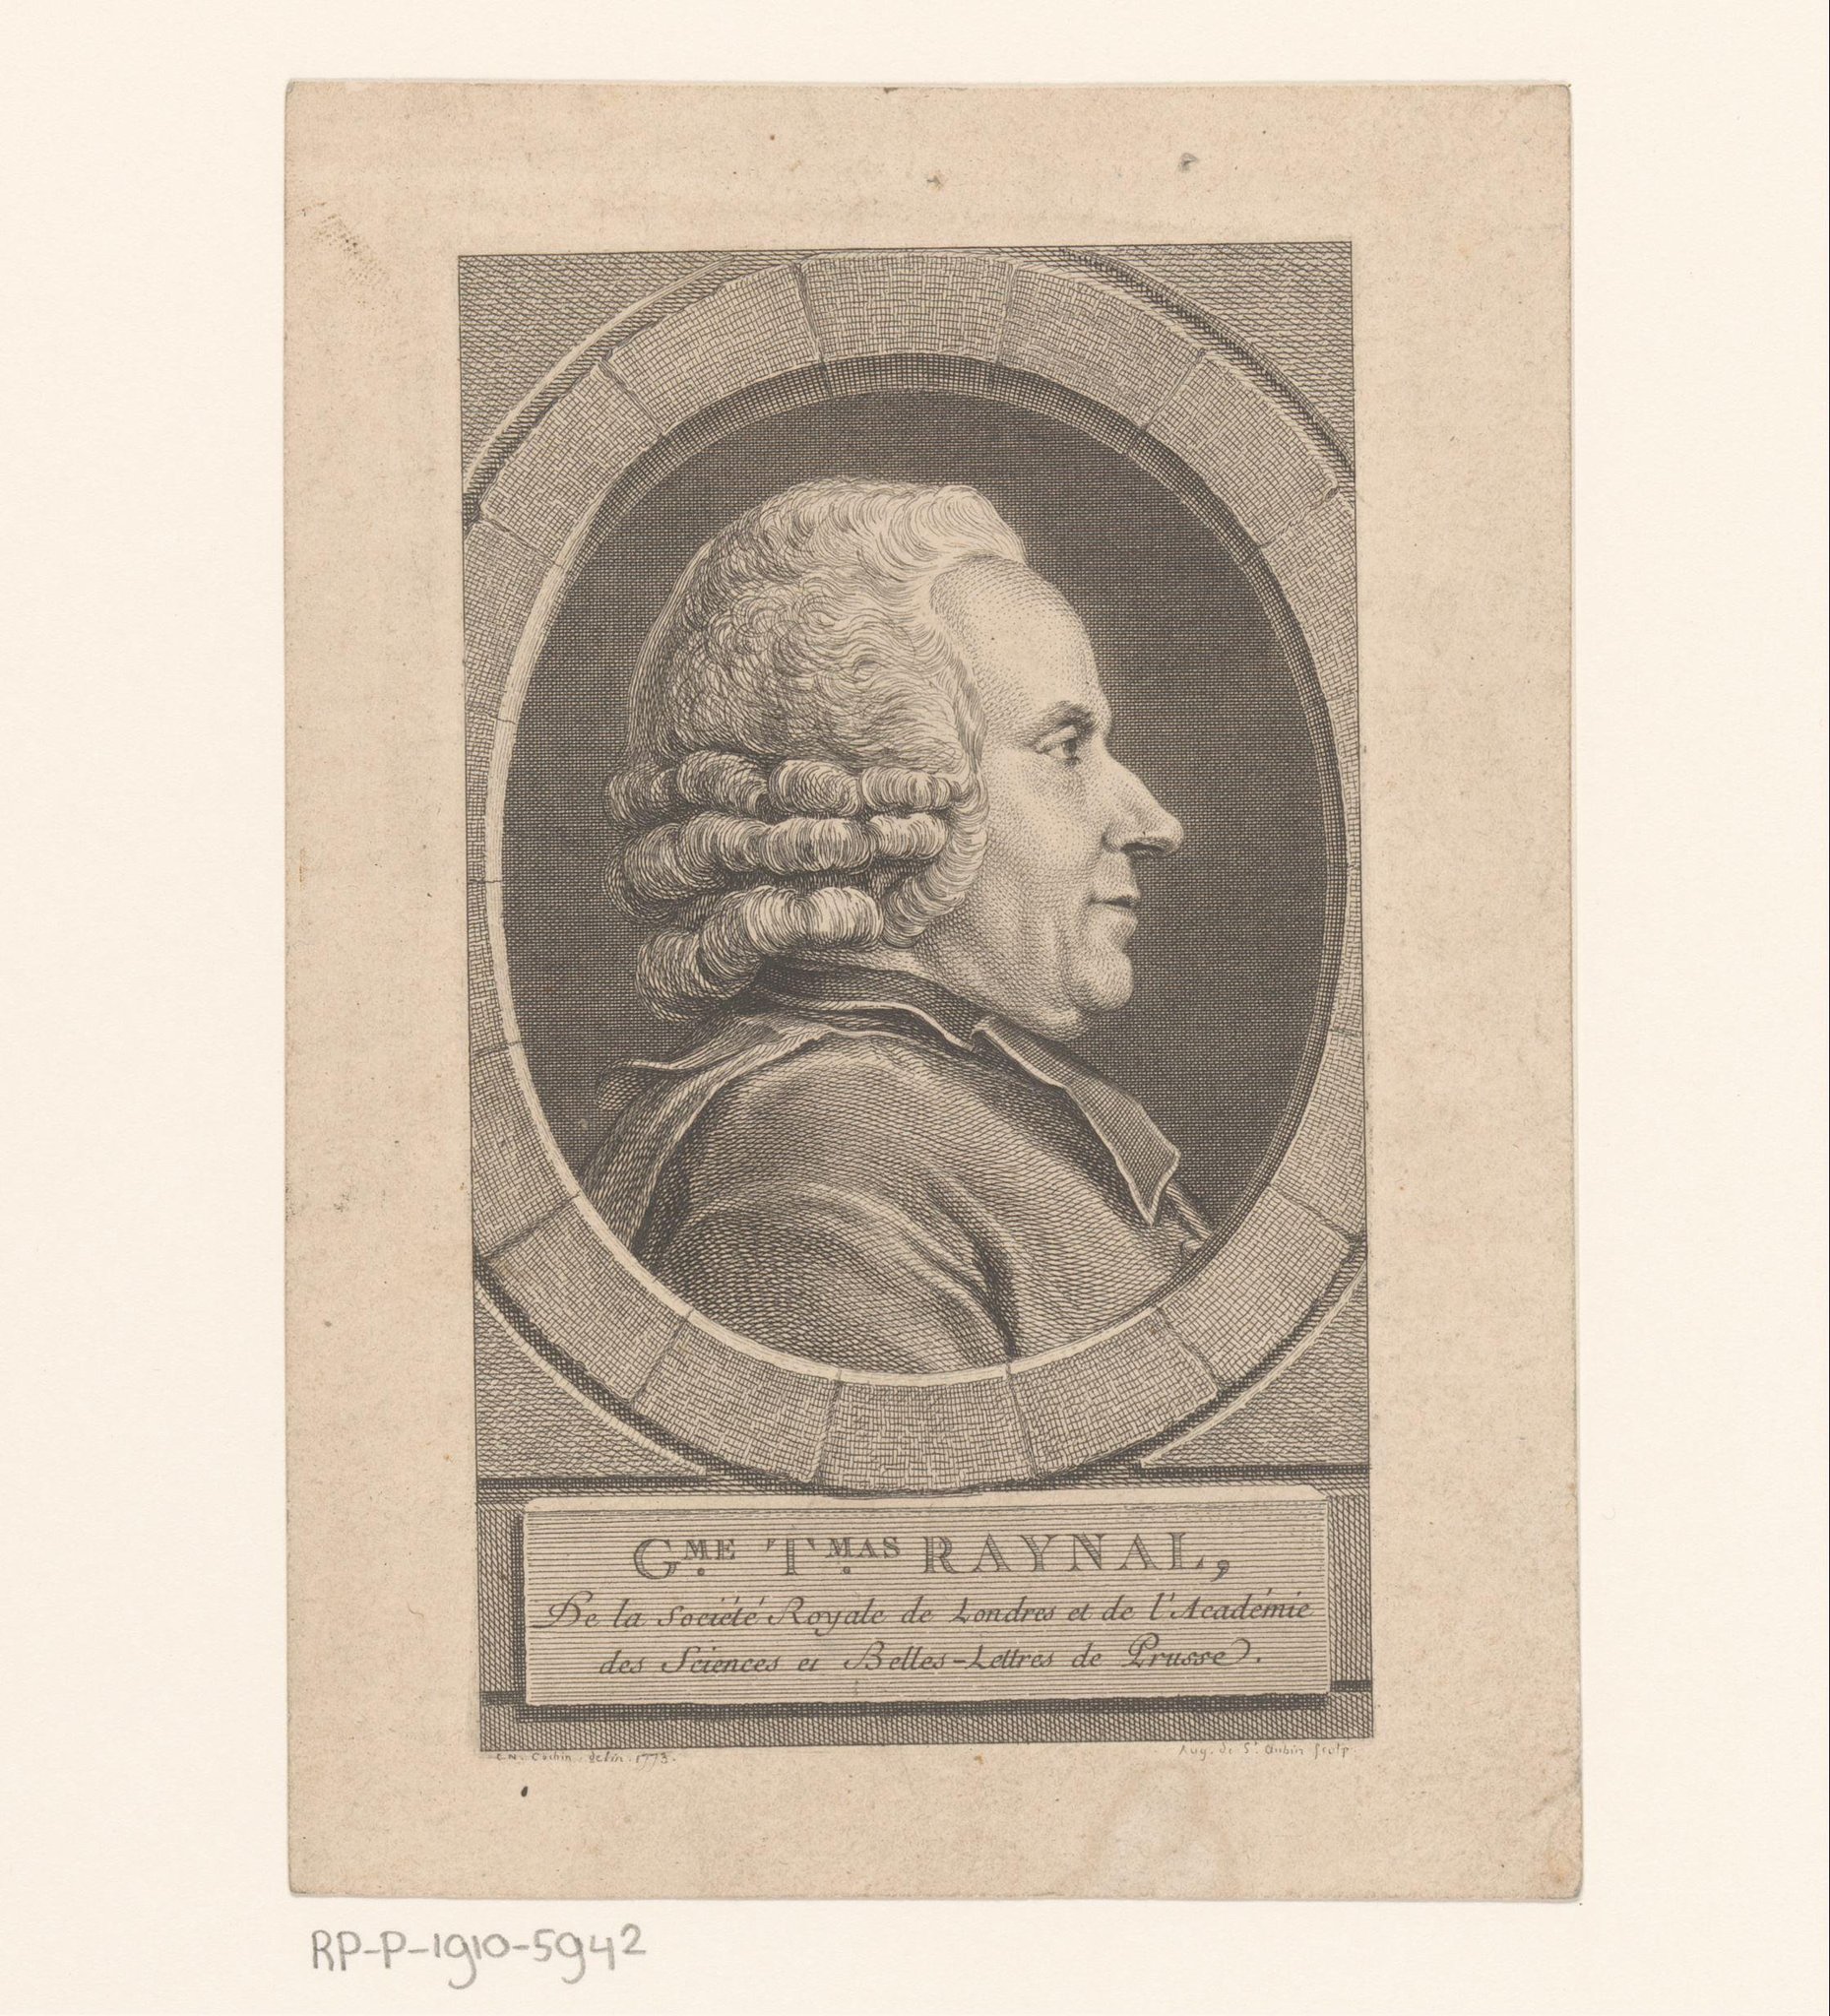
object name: print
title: Portret van Guillaume-Thomas François Raynal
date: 1773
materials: paper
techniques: engraving, etching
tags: paris, scholar, philosopher, historical persons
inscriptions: collector's mark: Lugt 2228